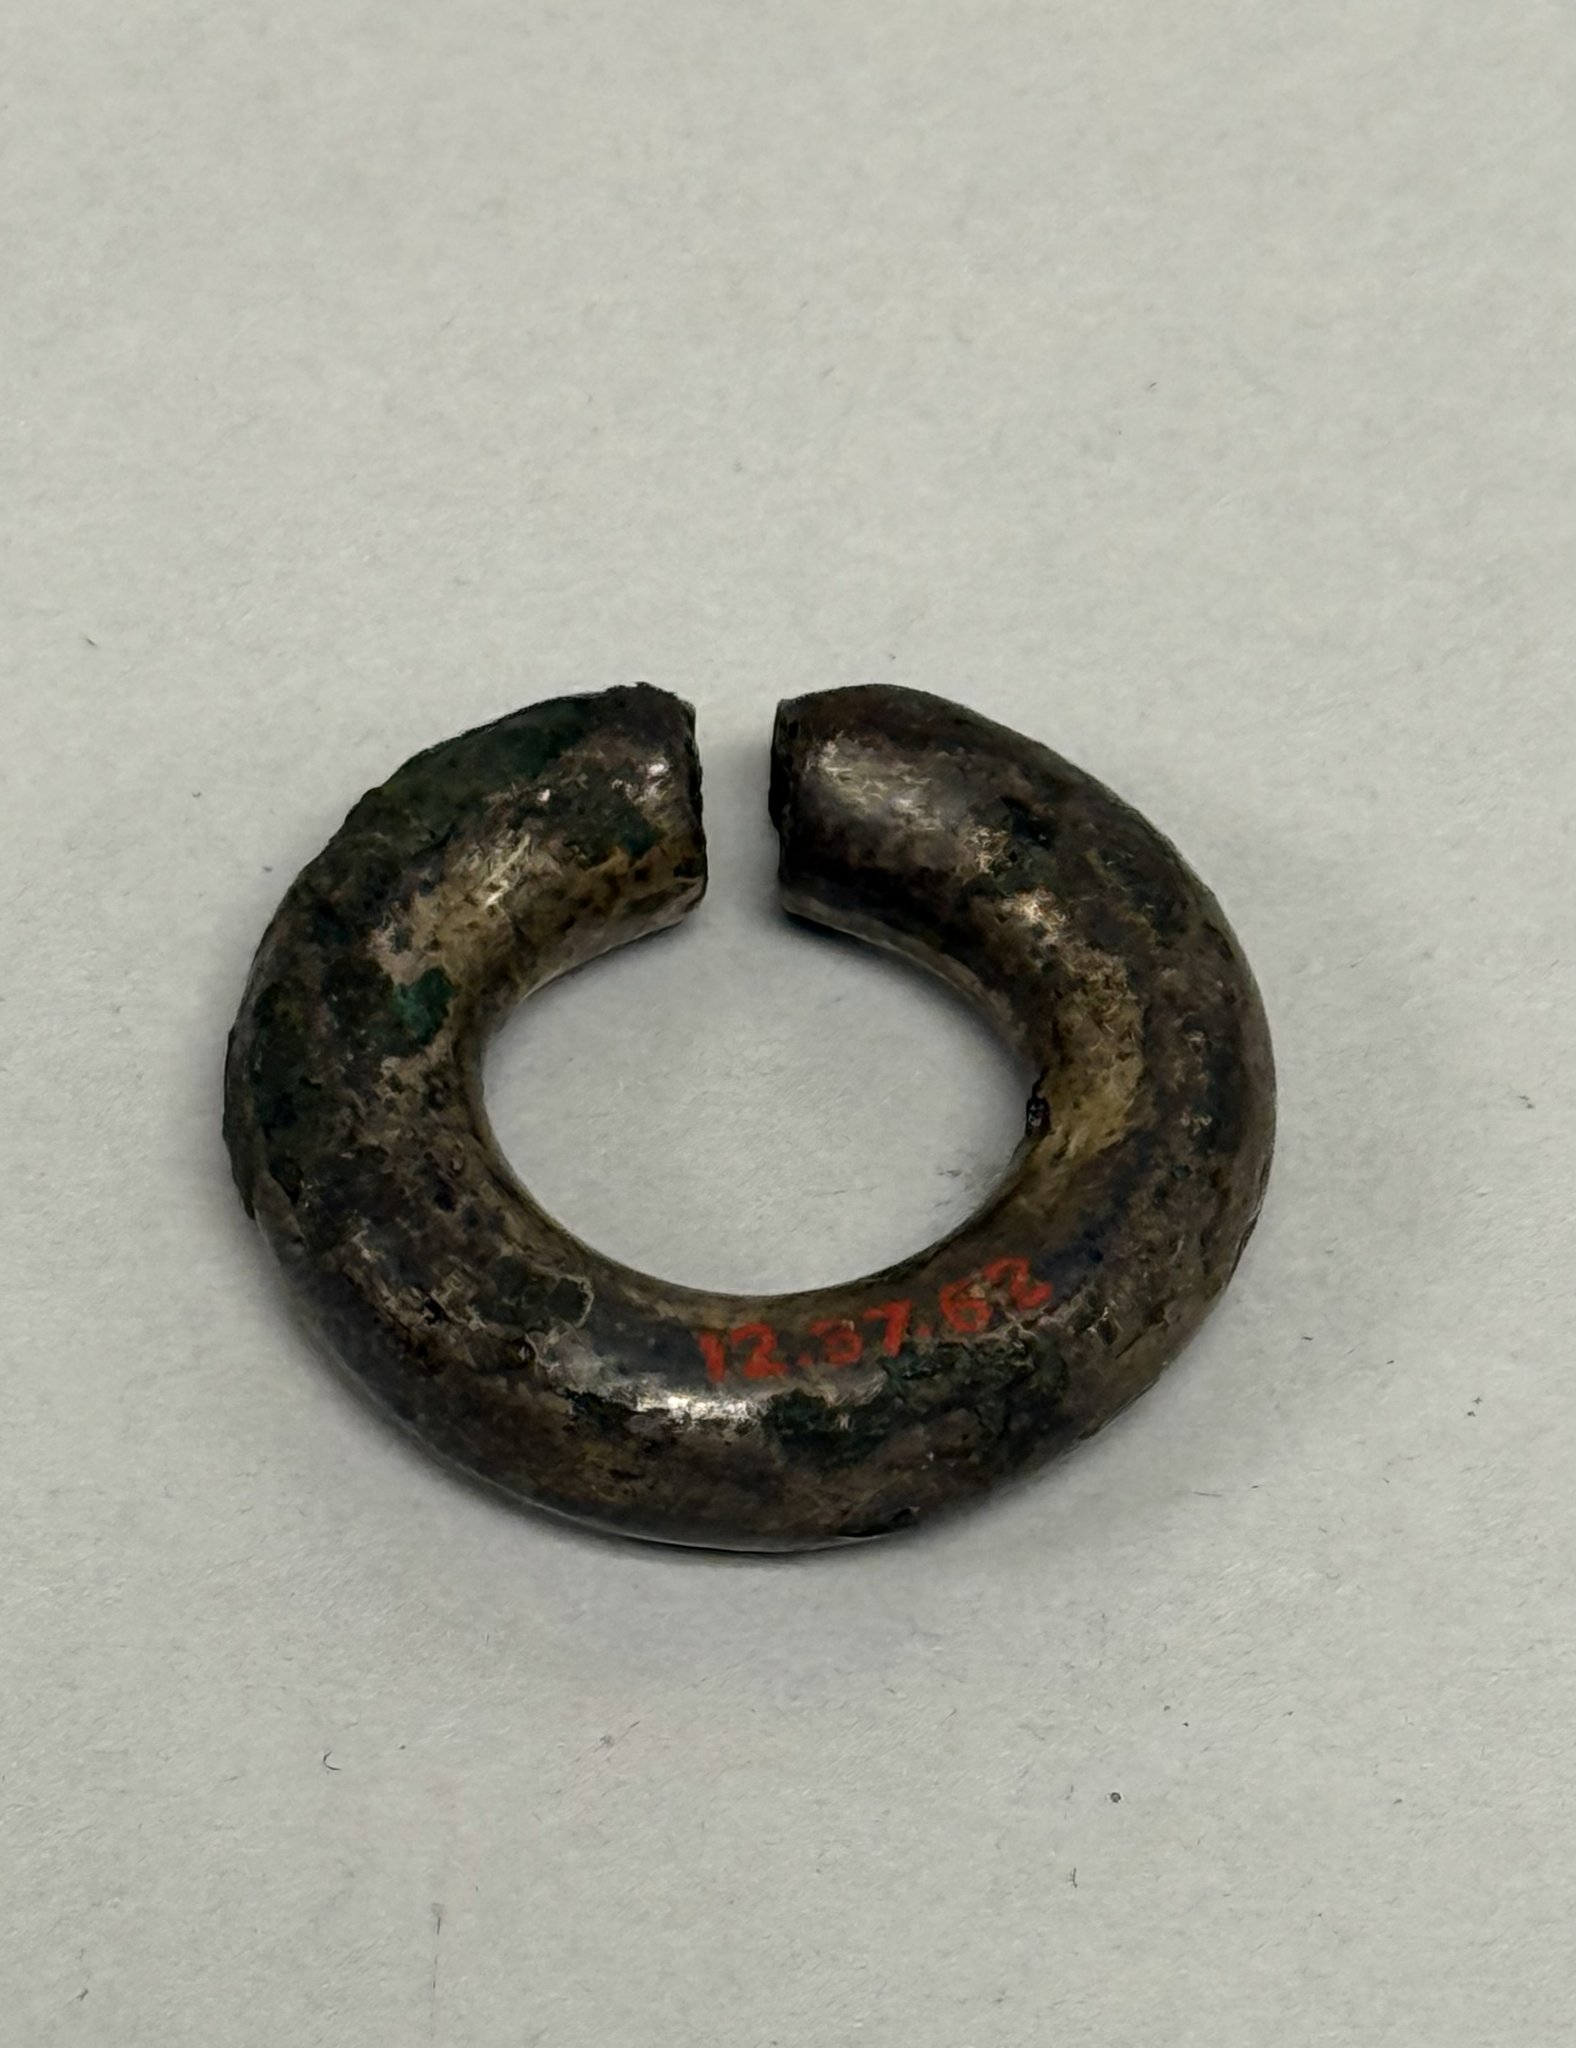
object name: earring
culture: japanese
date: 601-700